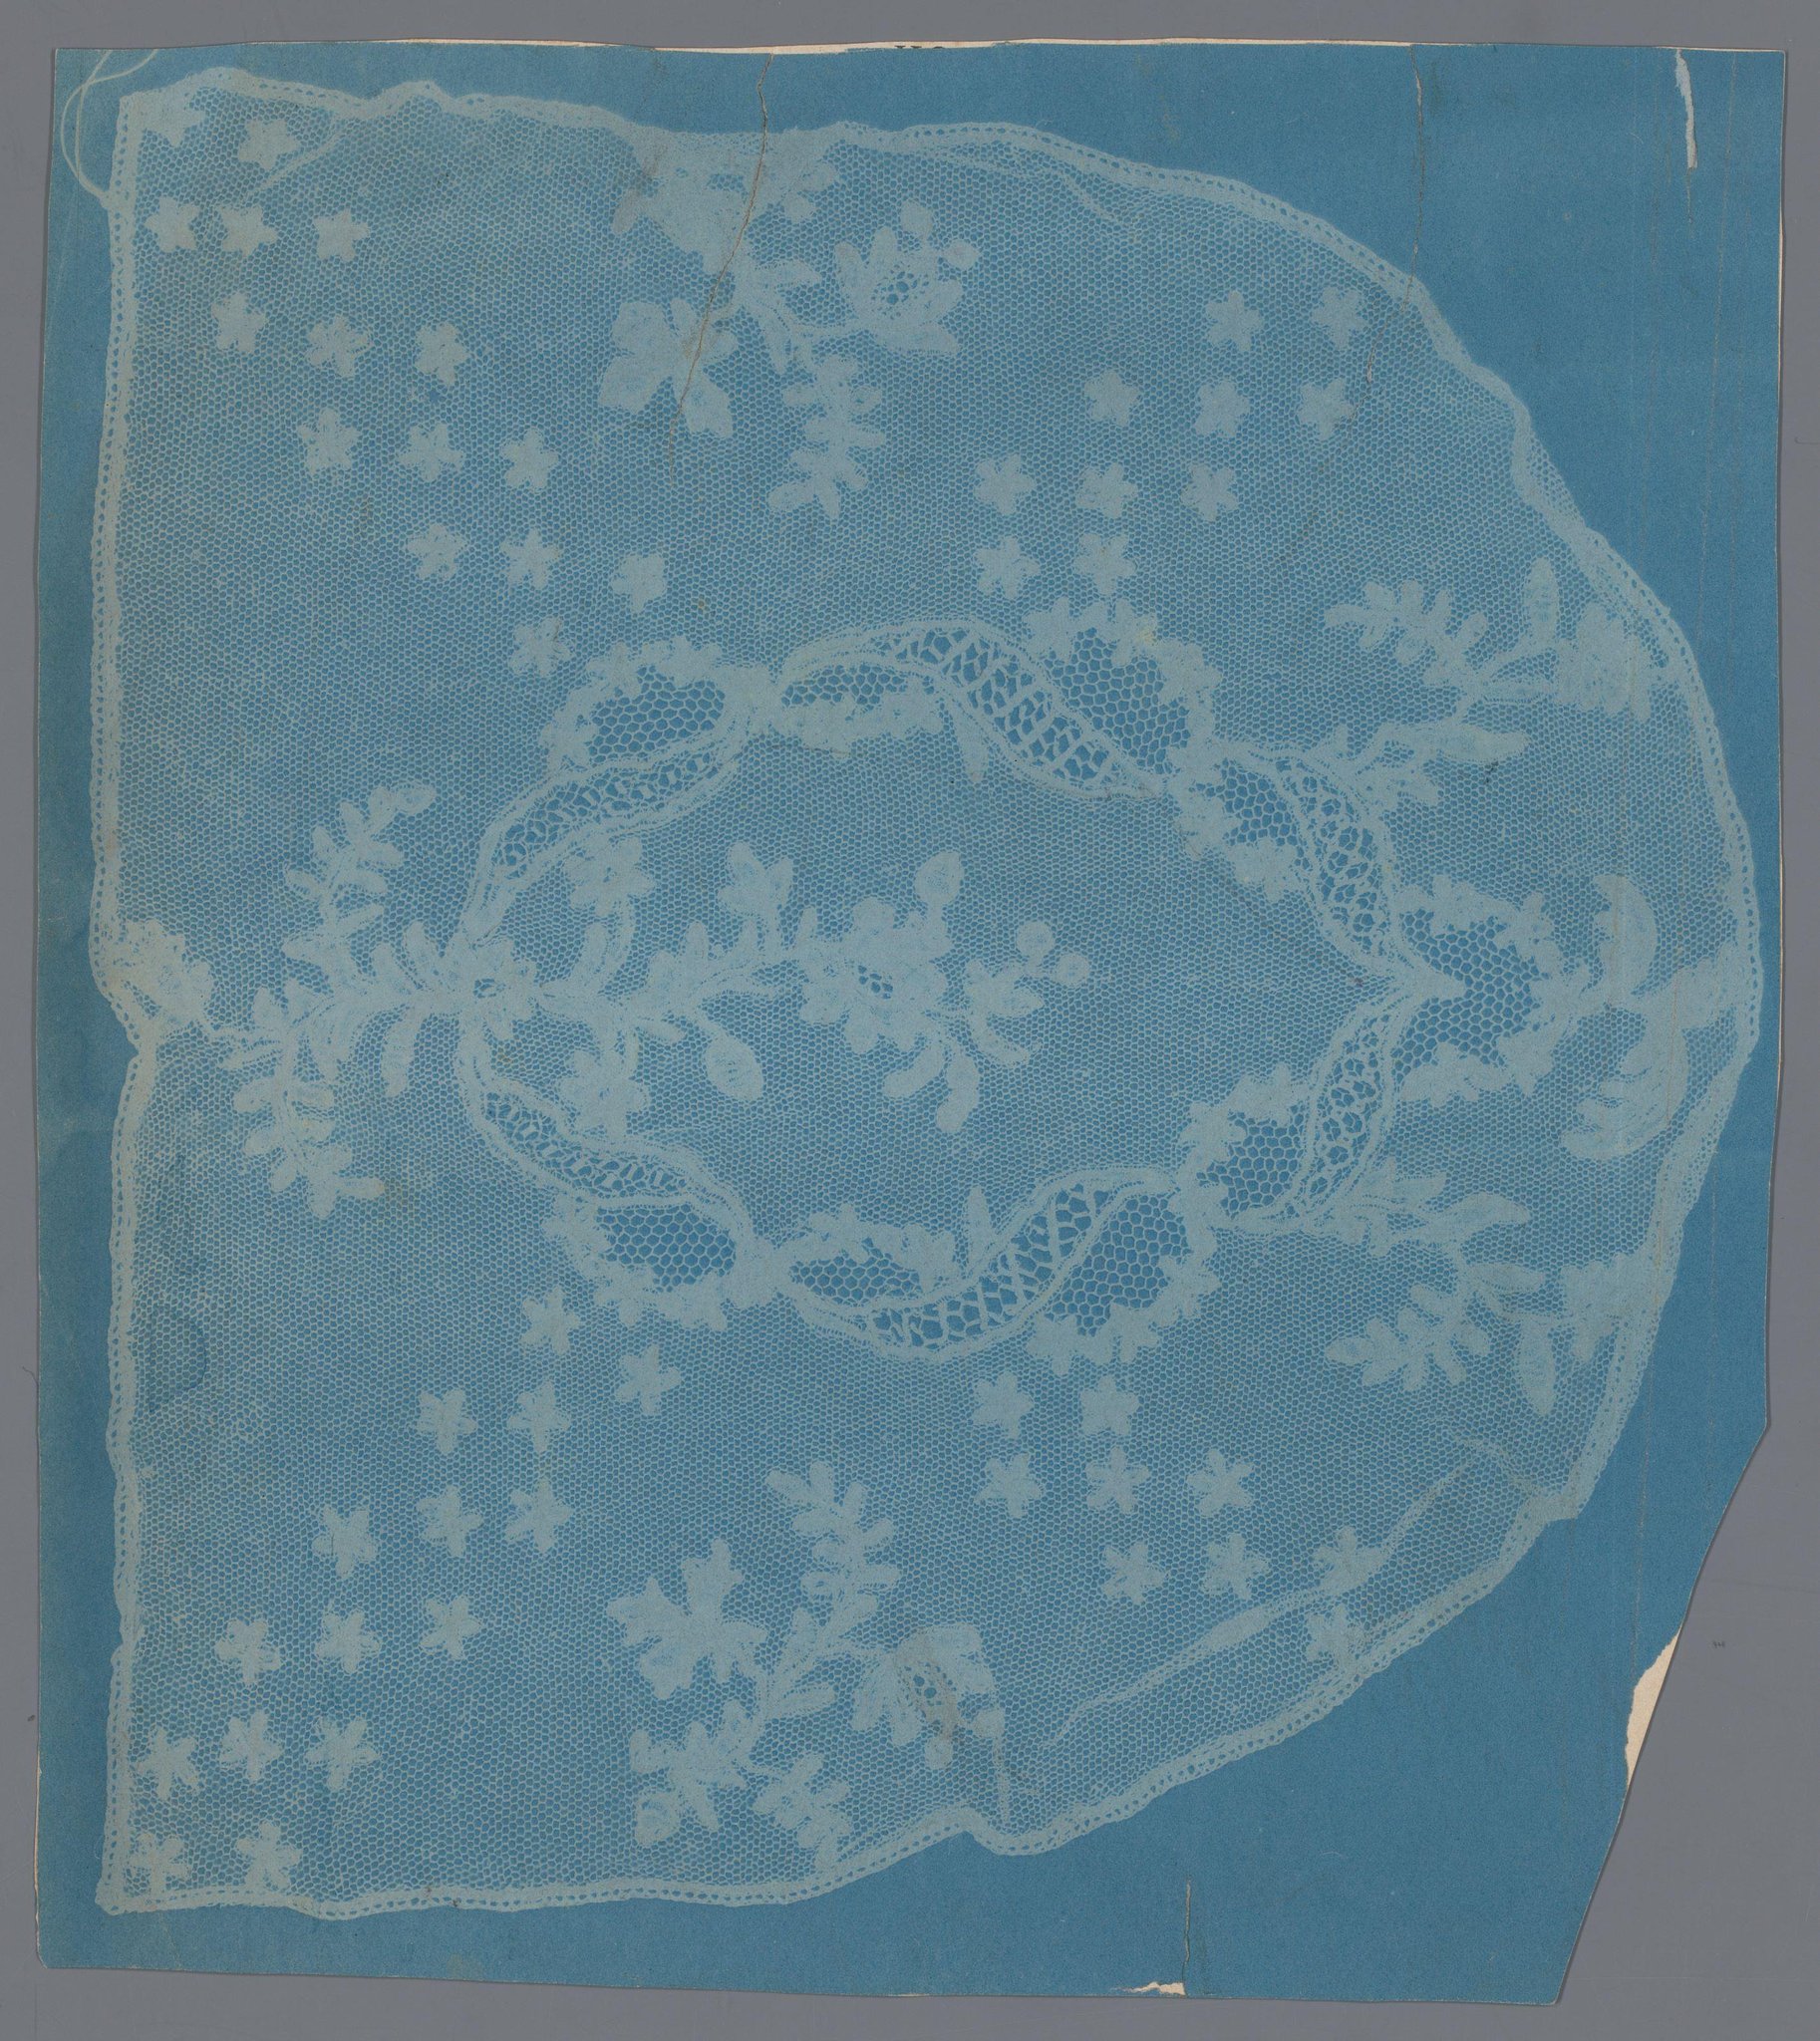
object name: photogram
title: Voorbeeld van kant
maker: Anonymous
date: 1890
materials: paper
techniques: cyanotype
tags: lace